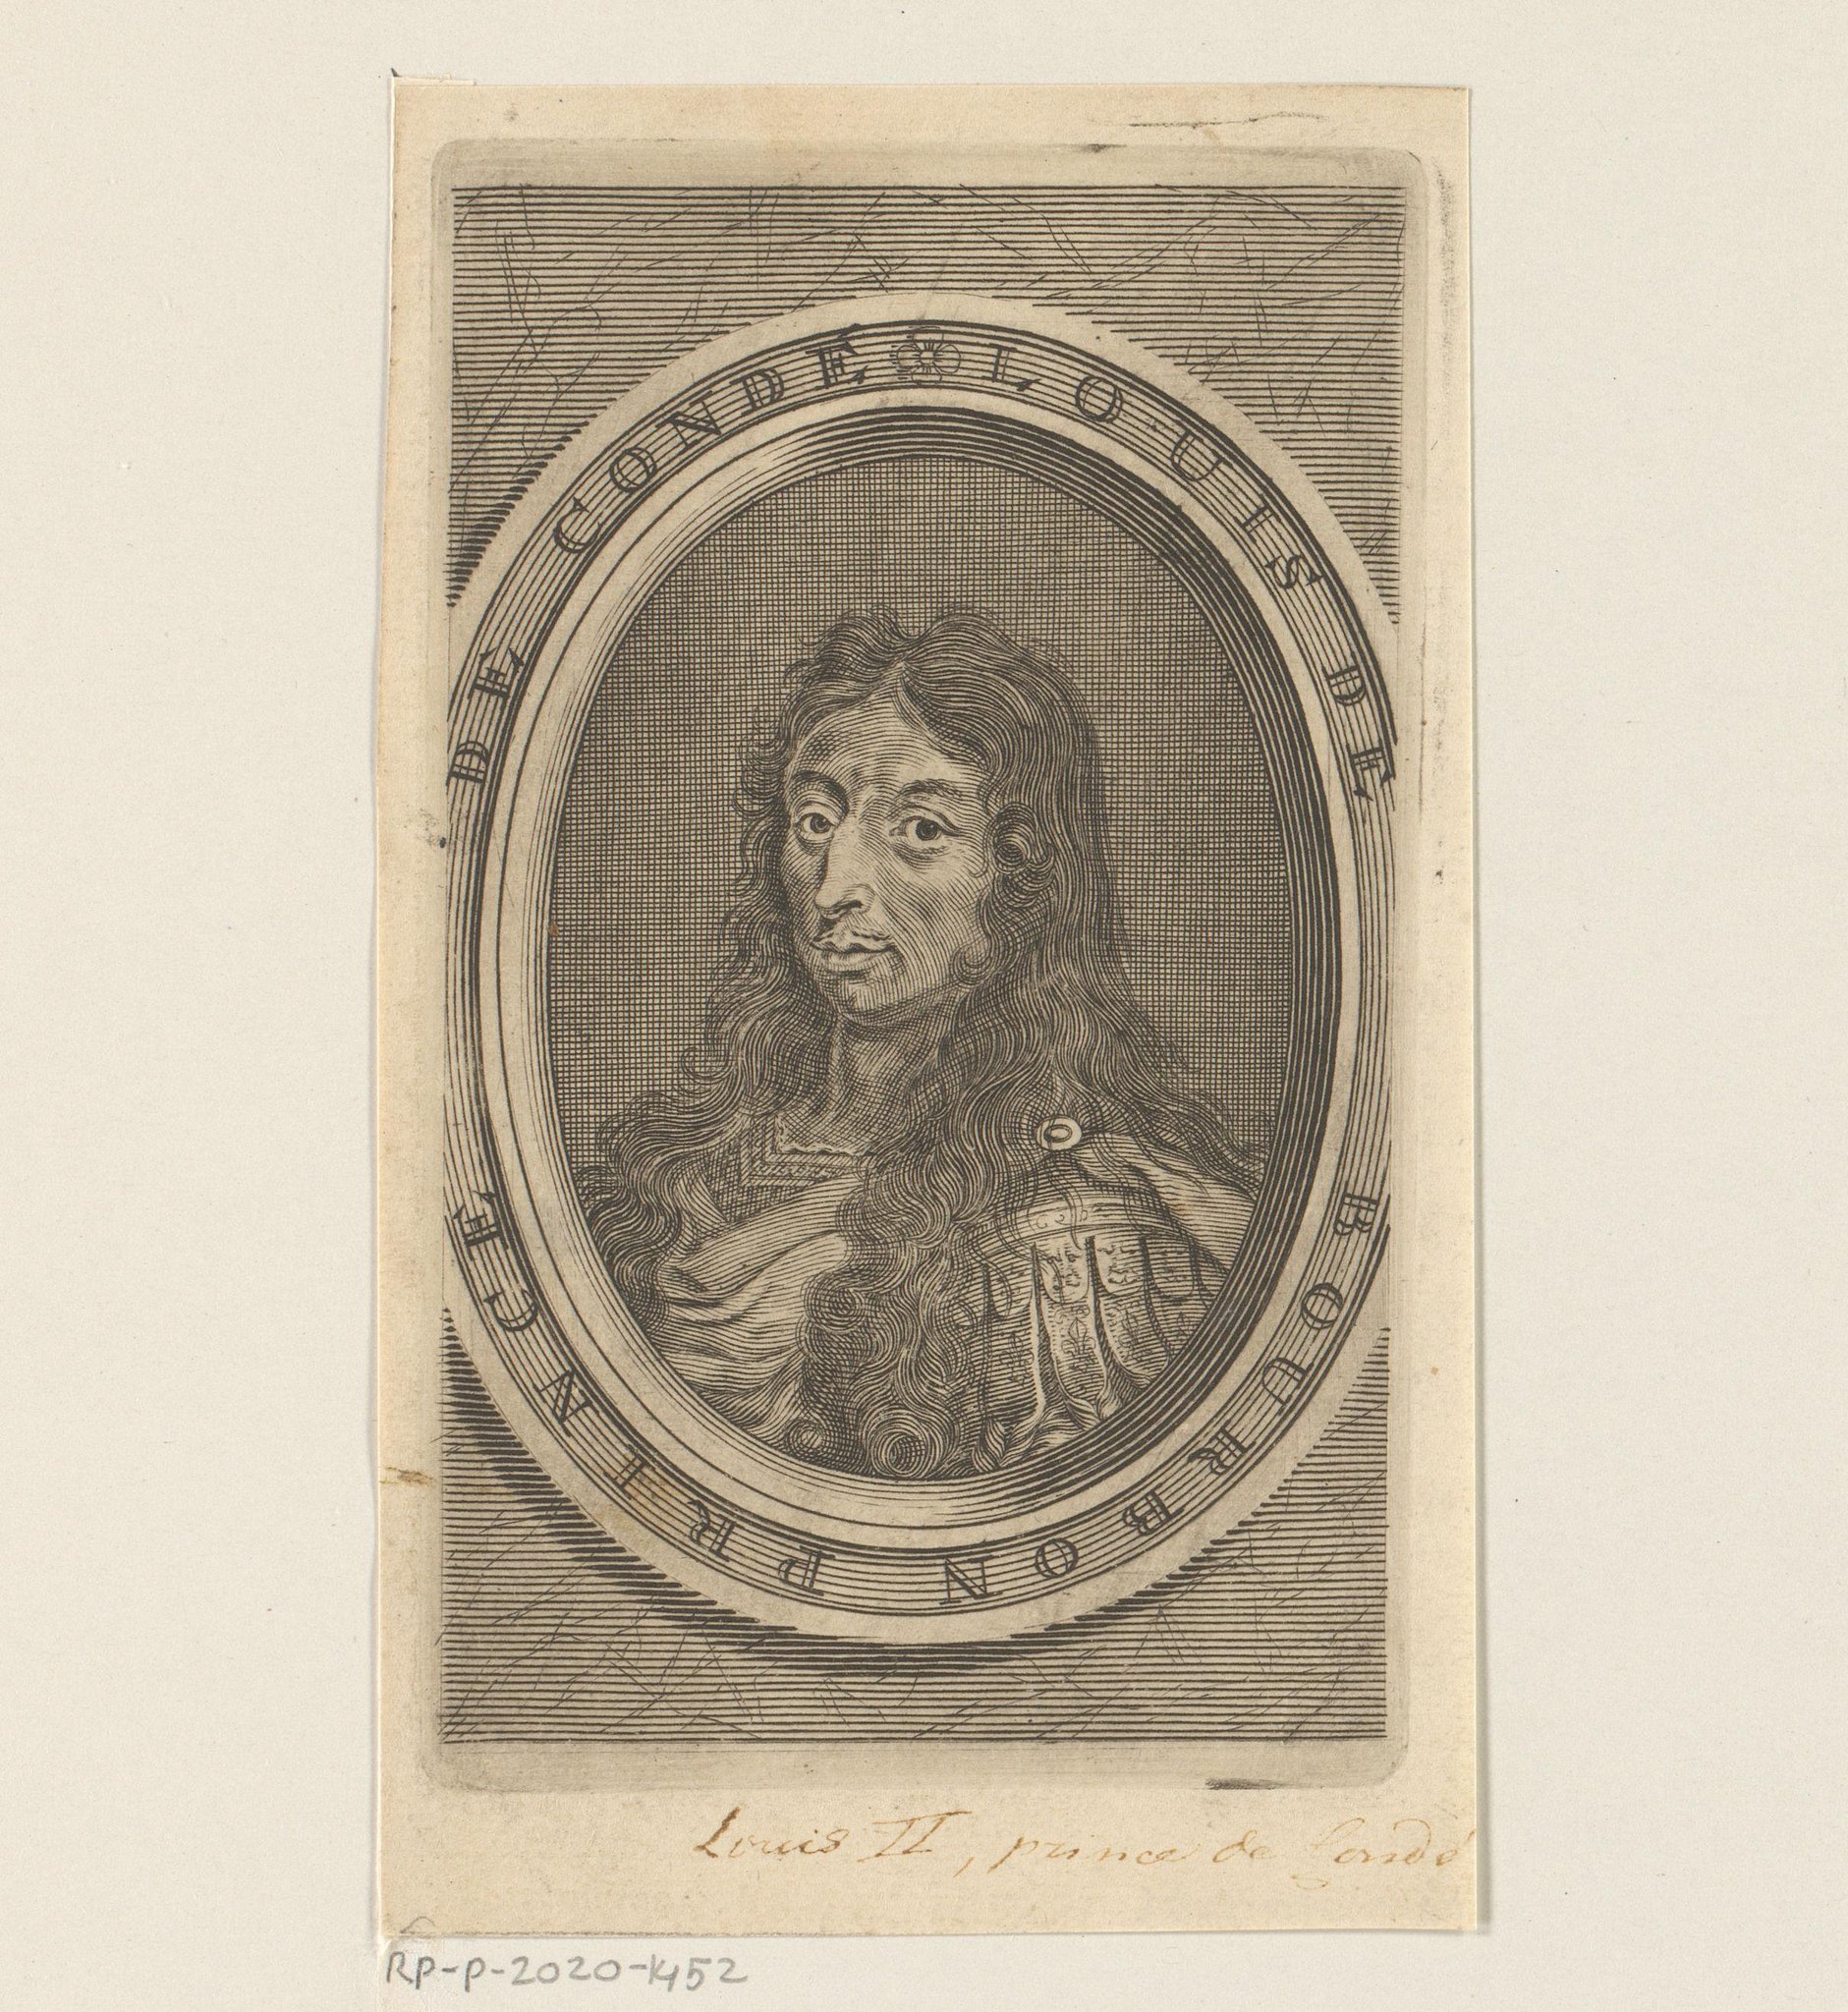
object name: print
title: Louis de Bourbon prince de Condé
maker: Anonymous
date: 1646-1699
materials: paper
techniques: engraving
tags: lodewijk ii de bourbon-condé (hertog van enghien), commander-in-chief, general, marshal, historical persons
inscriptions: inscription: ‘Louis II, prince de Condé’